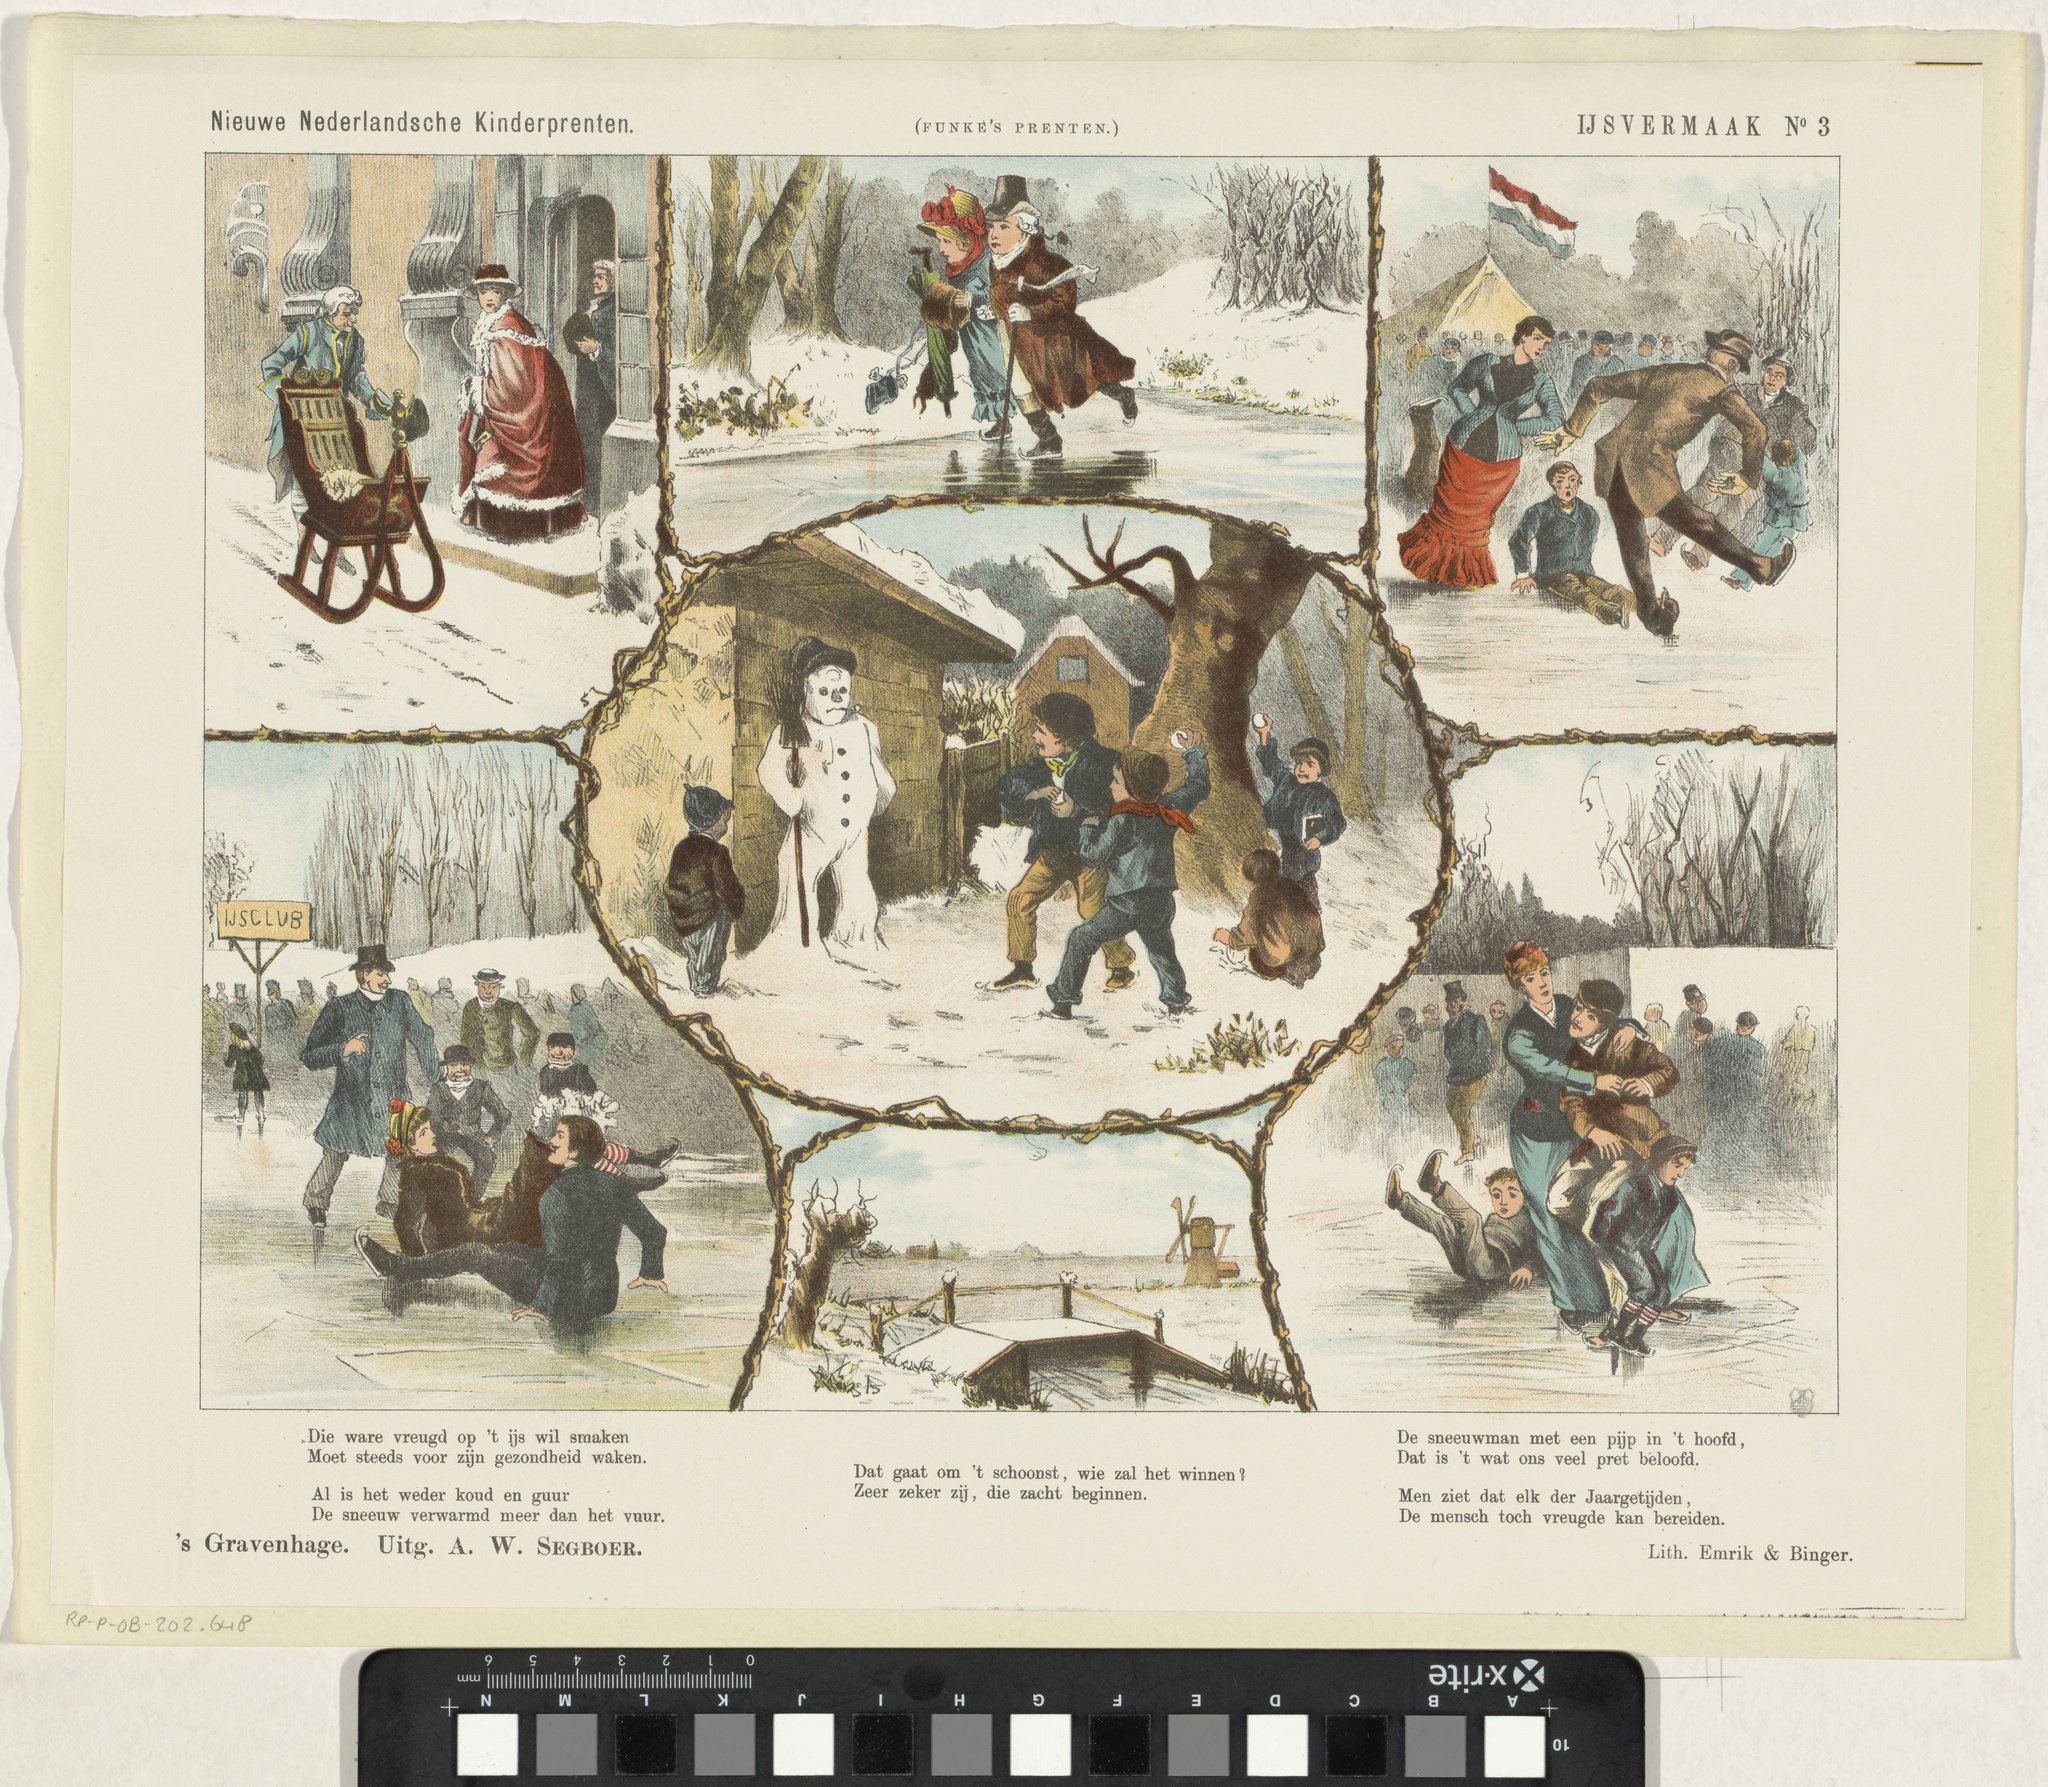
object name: print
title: Ijsvermaak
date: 1903-1919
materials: paper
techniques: lithograph, letterpress printing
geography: haarlem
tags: (making a) snowman, skates (winter sports)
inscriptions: collector's mark: Lugt 2760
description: Blad met 7 voorstellingen van winteractiviteiten, waaronder schaatsen, sleetje rijden en een sneeuwpop maken. In de ondermarge een vers. Genummerd rechtsboven: No 3.